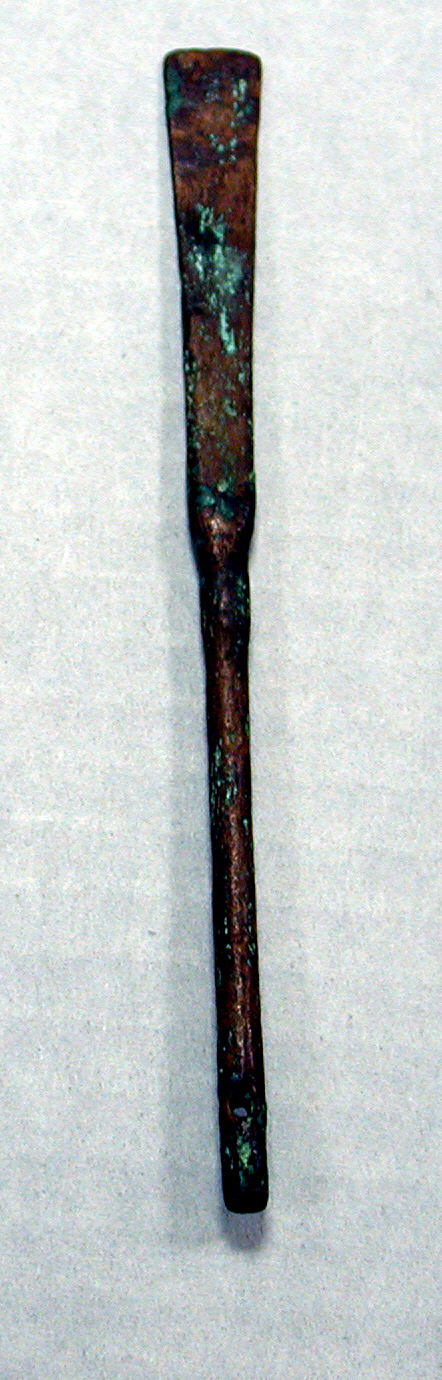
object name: chisel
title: Hammered Copper Chisel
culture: peruvian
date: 1-1566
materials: copper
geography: peru